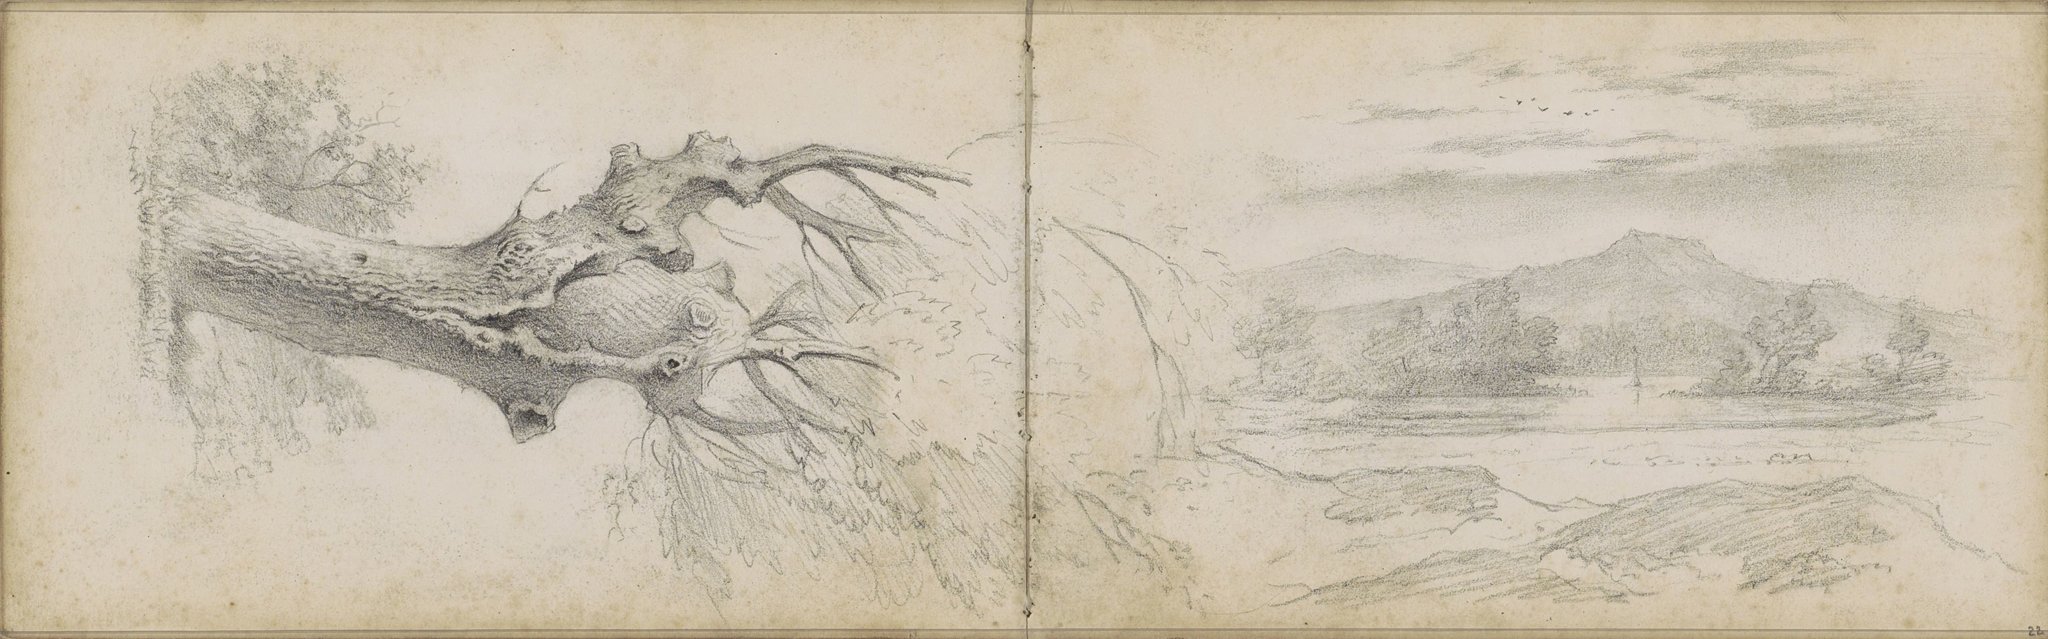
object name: sketchbook leaf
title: Boom en een heuvellandschap met water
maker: willem cornelis rip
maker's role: draughtsman, painter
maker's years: 1856-1922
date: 1874-1875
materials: paper, pencil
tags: low hill country, trees, landscapes with waters, waterscapes, seascapes (in the temperate zone)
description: Blad 21 verso en 22 recto uit een schetsboek met 46 bladen.